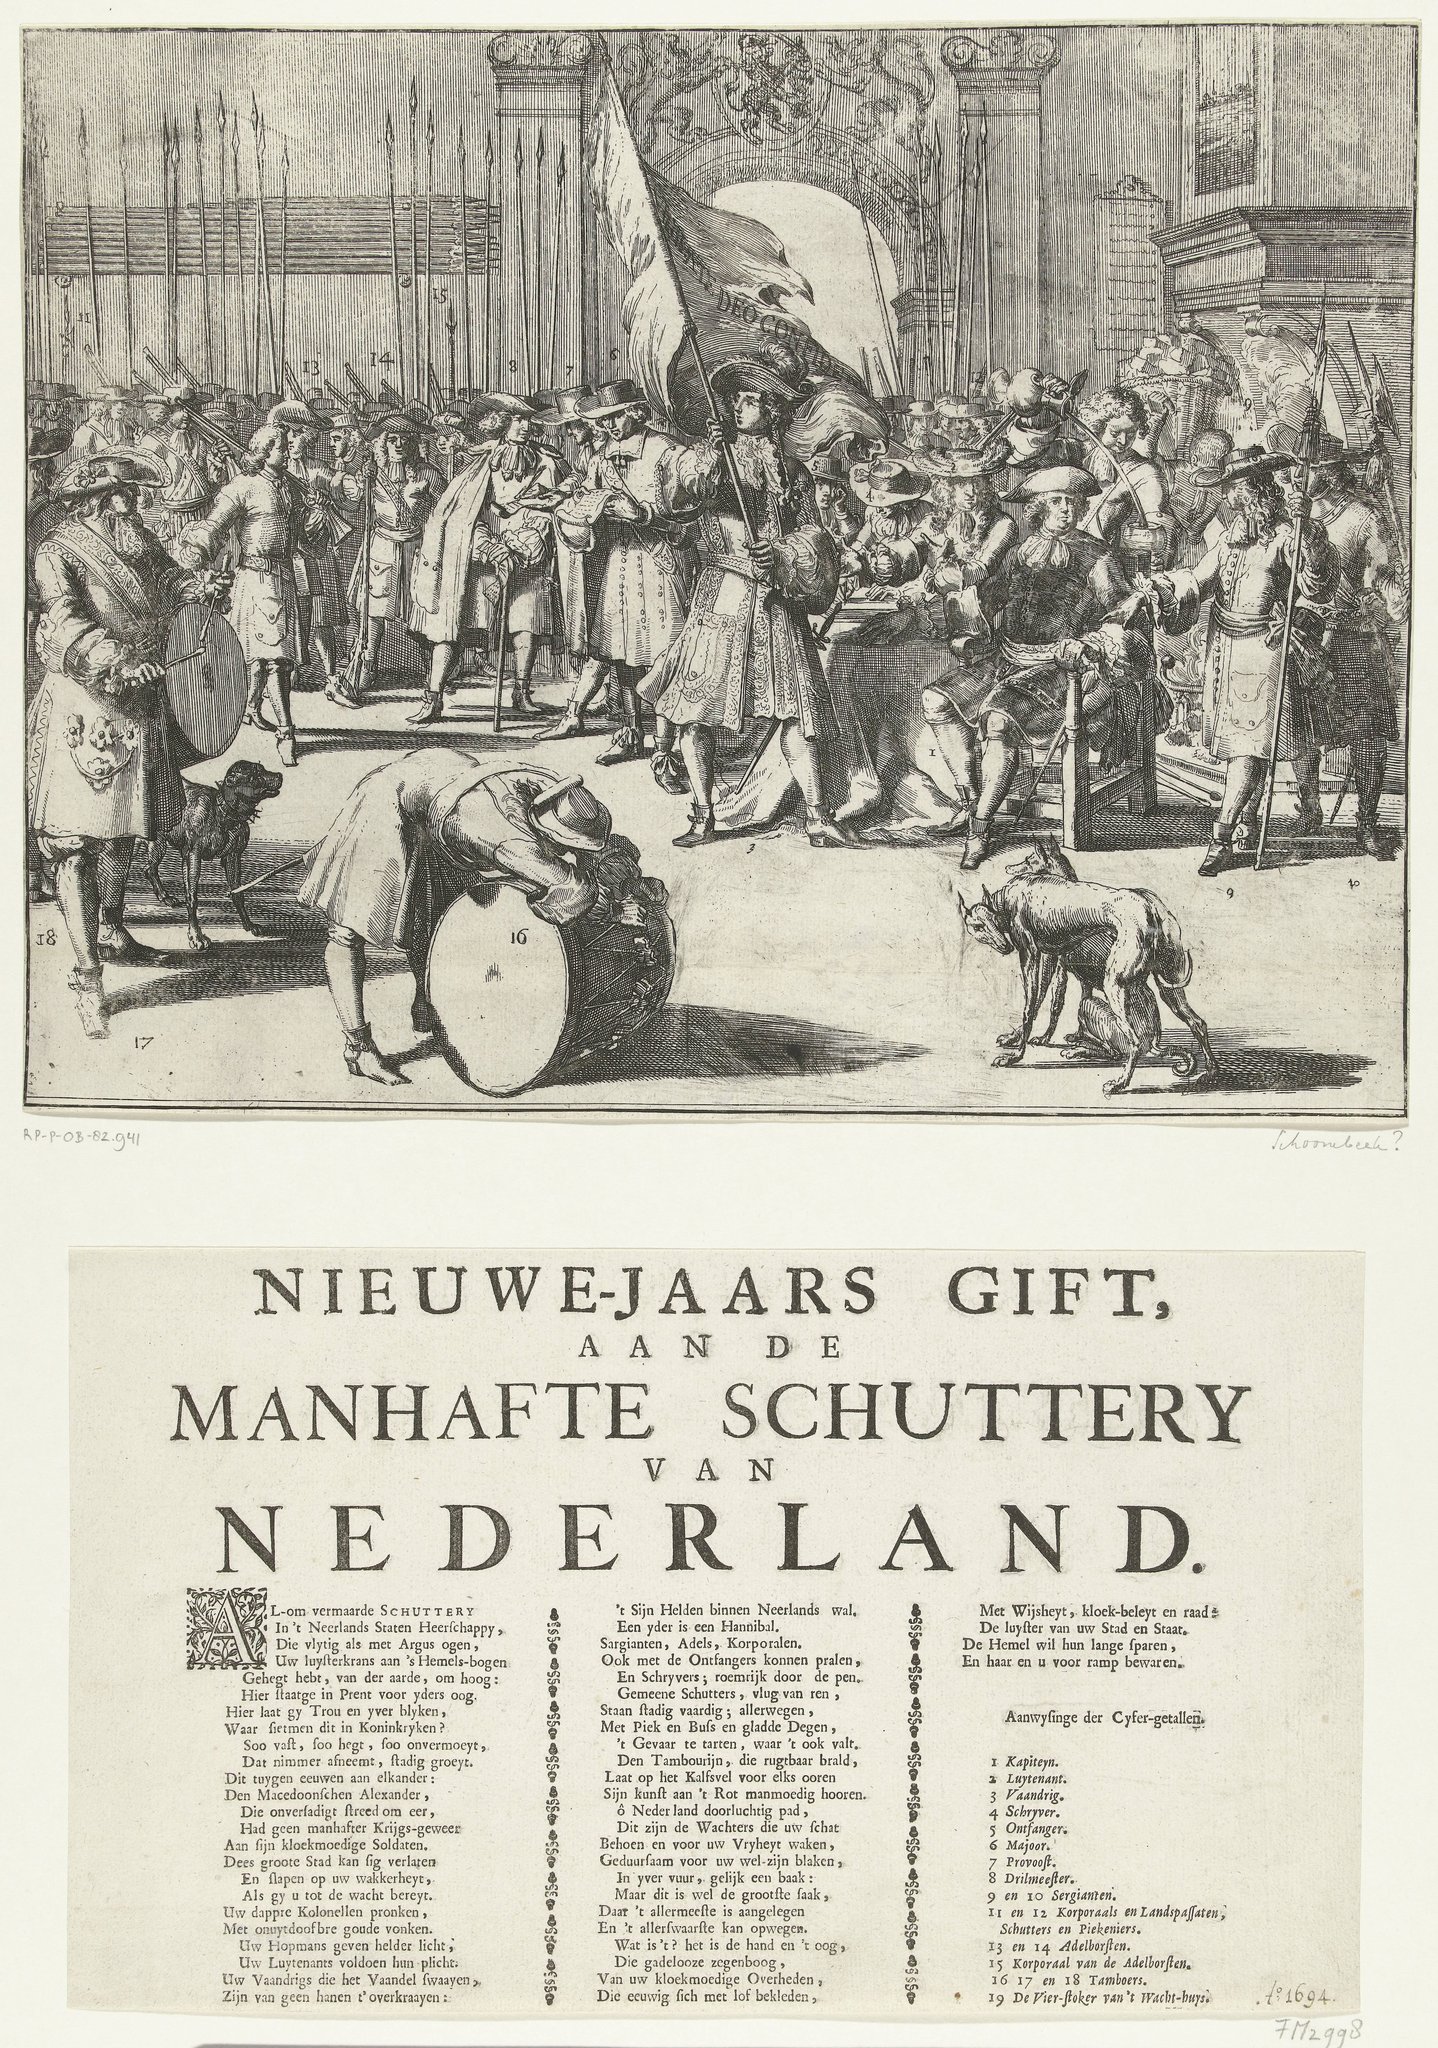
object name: new year card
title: Nieuwjaarsprent voor de schutterij, ca. 1700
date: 1690-1710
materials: paper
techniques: etching, letterpress printing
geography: northern netherlands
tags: warfare; military affairs (+ citizen soldiery, civil guard, citizen militia)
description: Nieuwjaarsprent voor de schutterij. Wachtlokaal met een compagnie van de schutterij. Bij de plaat behoort een tekstblad met een vers in drie kolommen met de legenda 1-16 op de rangen van de schutters.